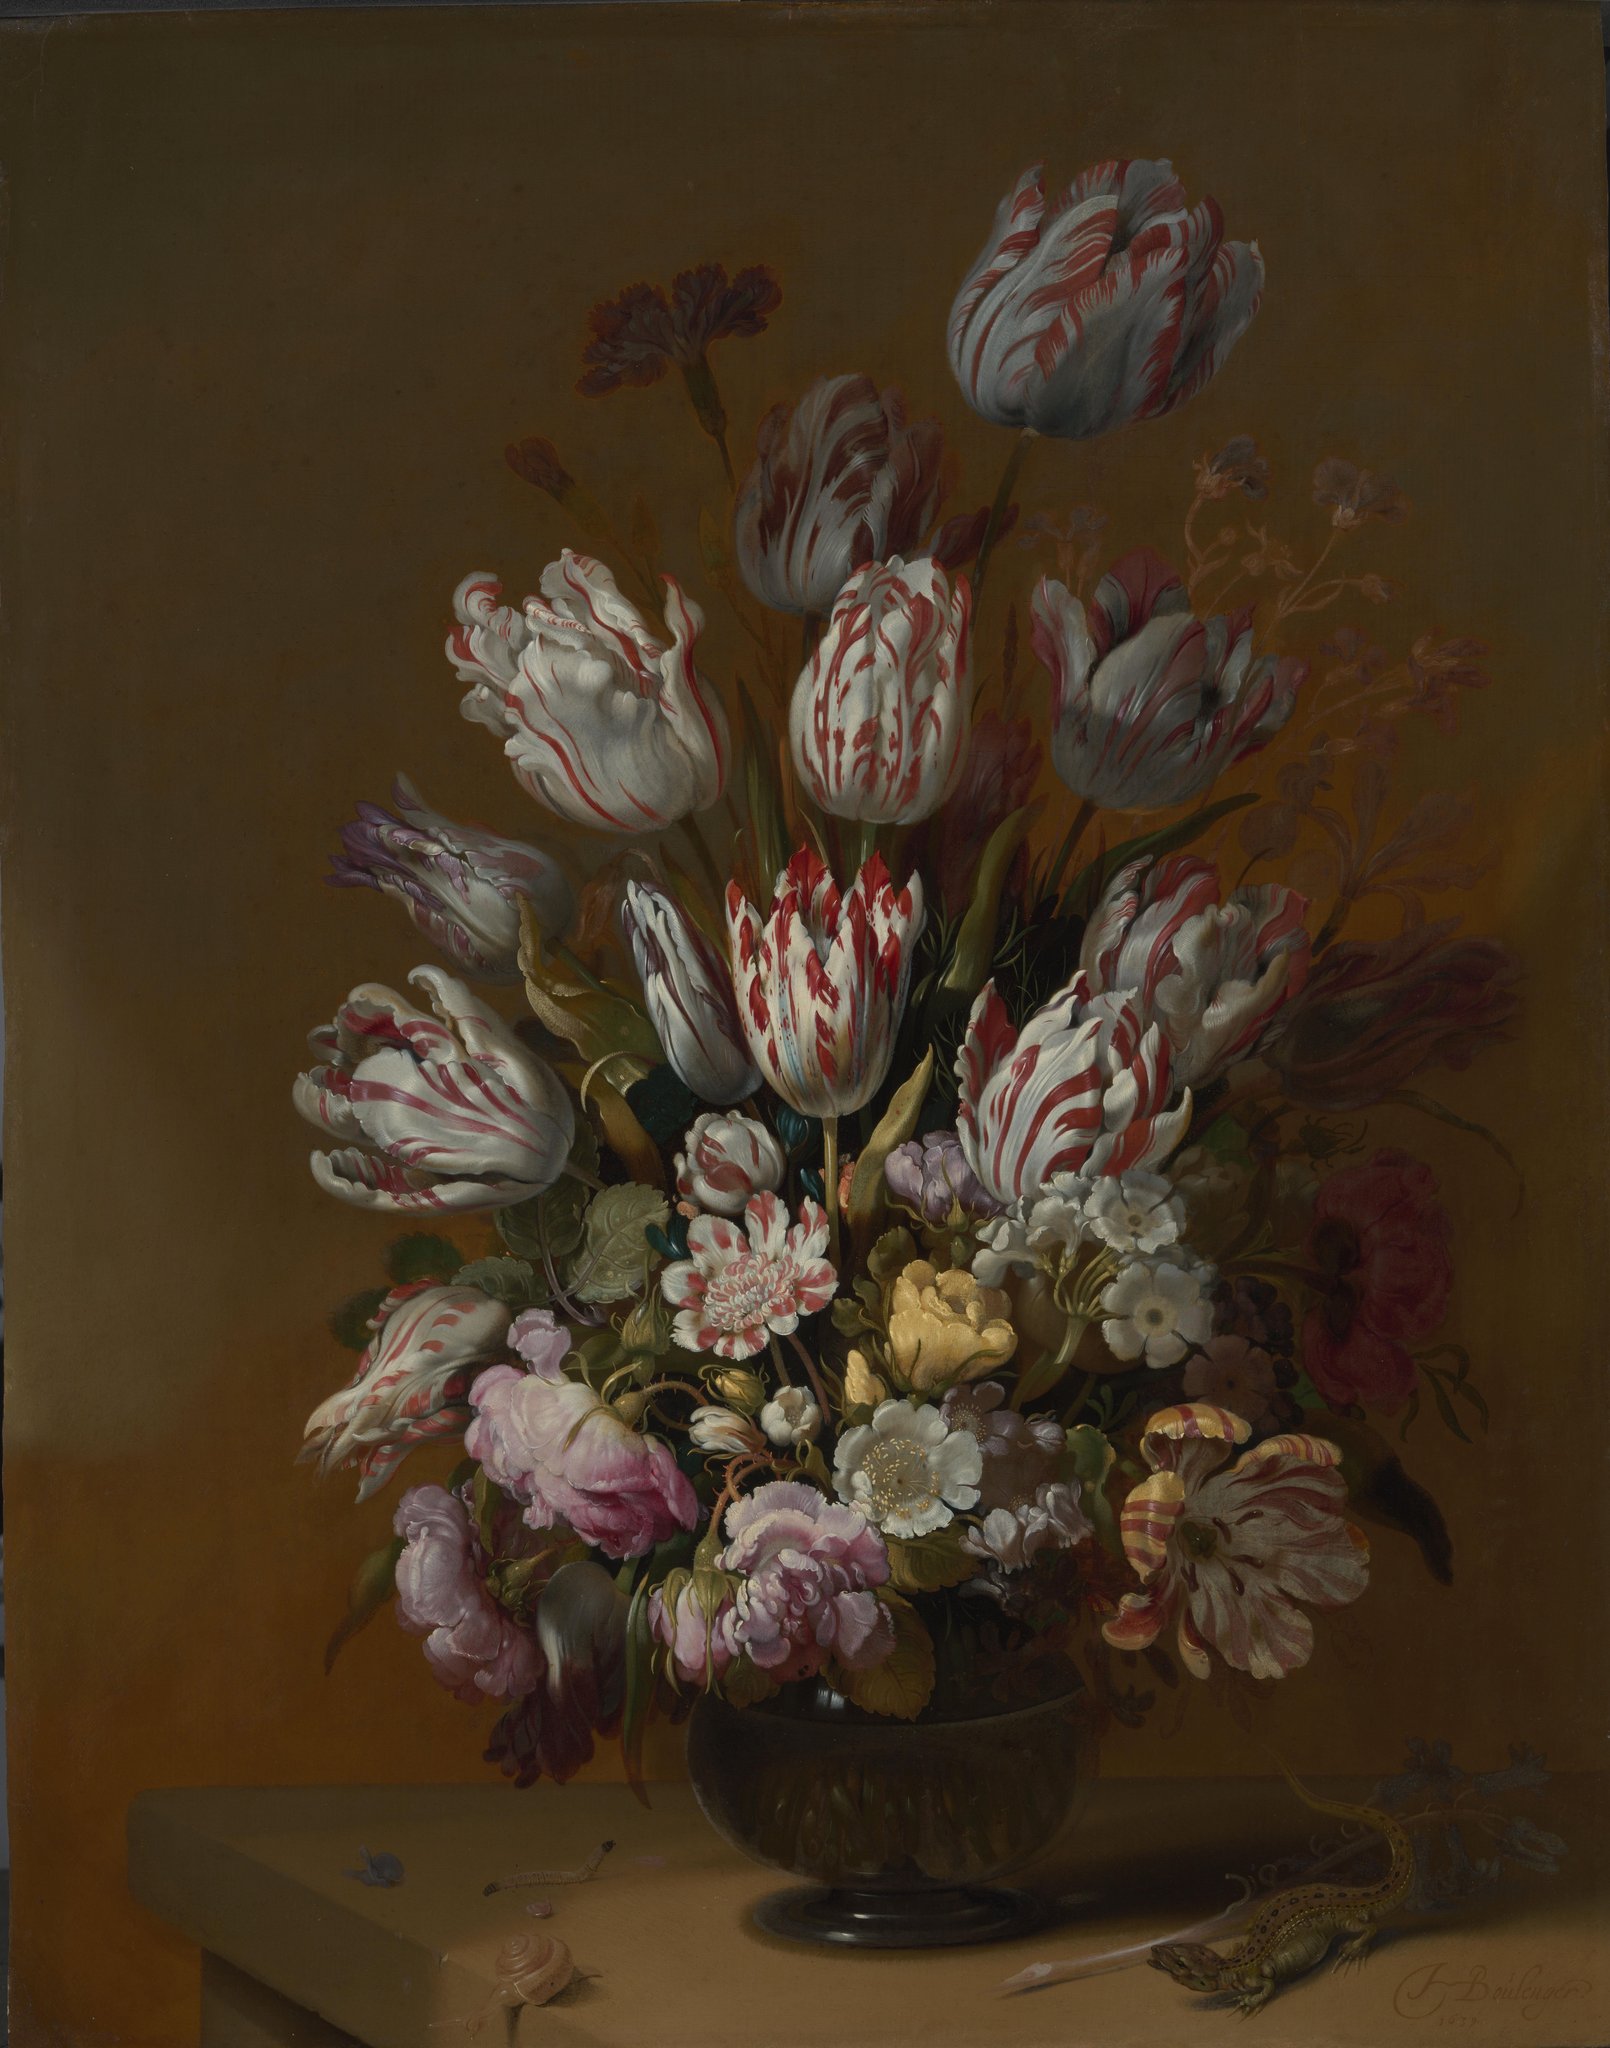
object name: painting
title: Floral Still Life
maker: hans bollongier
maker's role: painter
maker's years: 1598-1675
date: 1639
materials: oil, panel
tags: lizards: lizard, flowers: tulip, insects: caterpillar, flowers in a vase, molluscs: snail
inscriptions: signature and date, bottom right (H and B ligated): ‘HBoulenger. / 1639’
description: This exuberant bouquet may look natural, but tulips, anemones, roses and carnations do not all bloom at the same time. Bollongier nevertheless managed to assemble a balanced composition. The still life was painted shortly after the Dutch stock market crashed in 1637, when many people went bankrupt due to the speculation in tulip bulbs. This festive bouquet may thus refer to the transience of earthly matters.